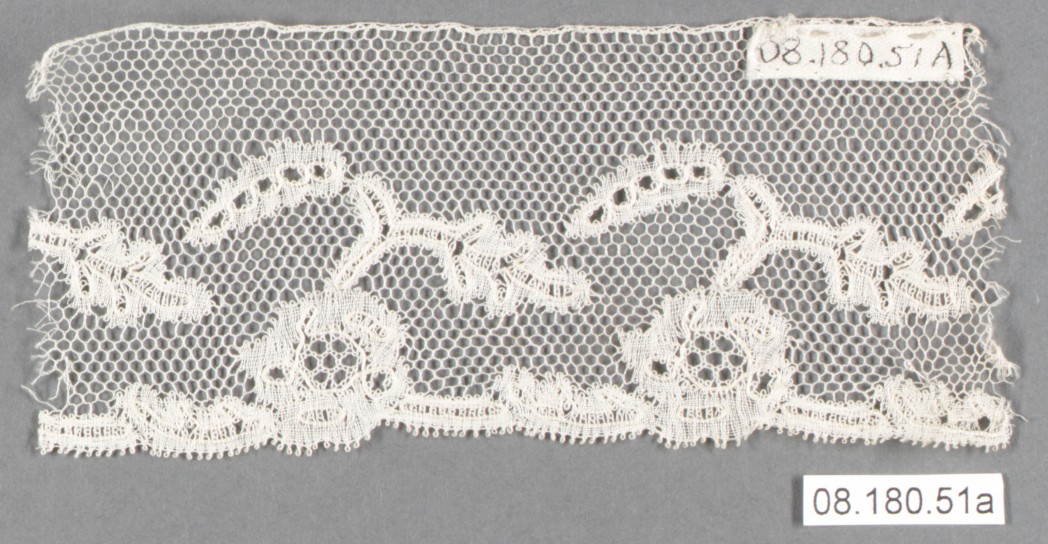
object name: fragment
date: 1801-1900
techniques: lace